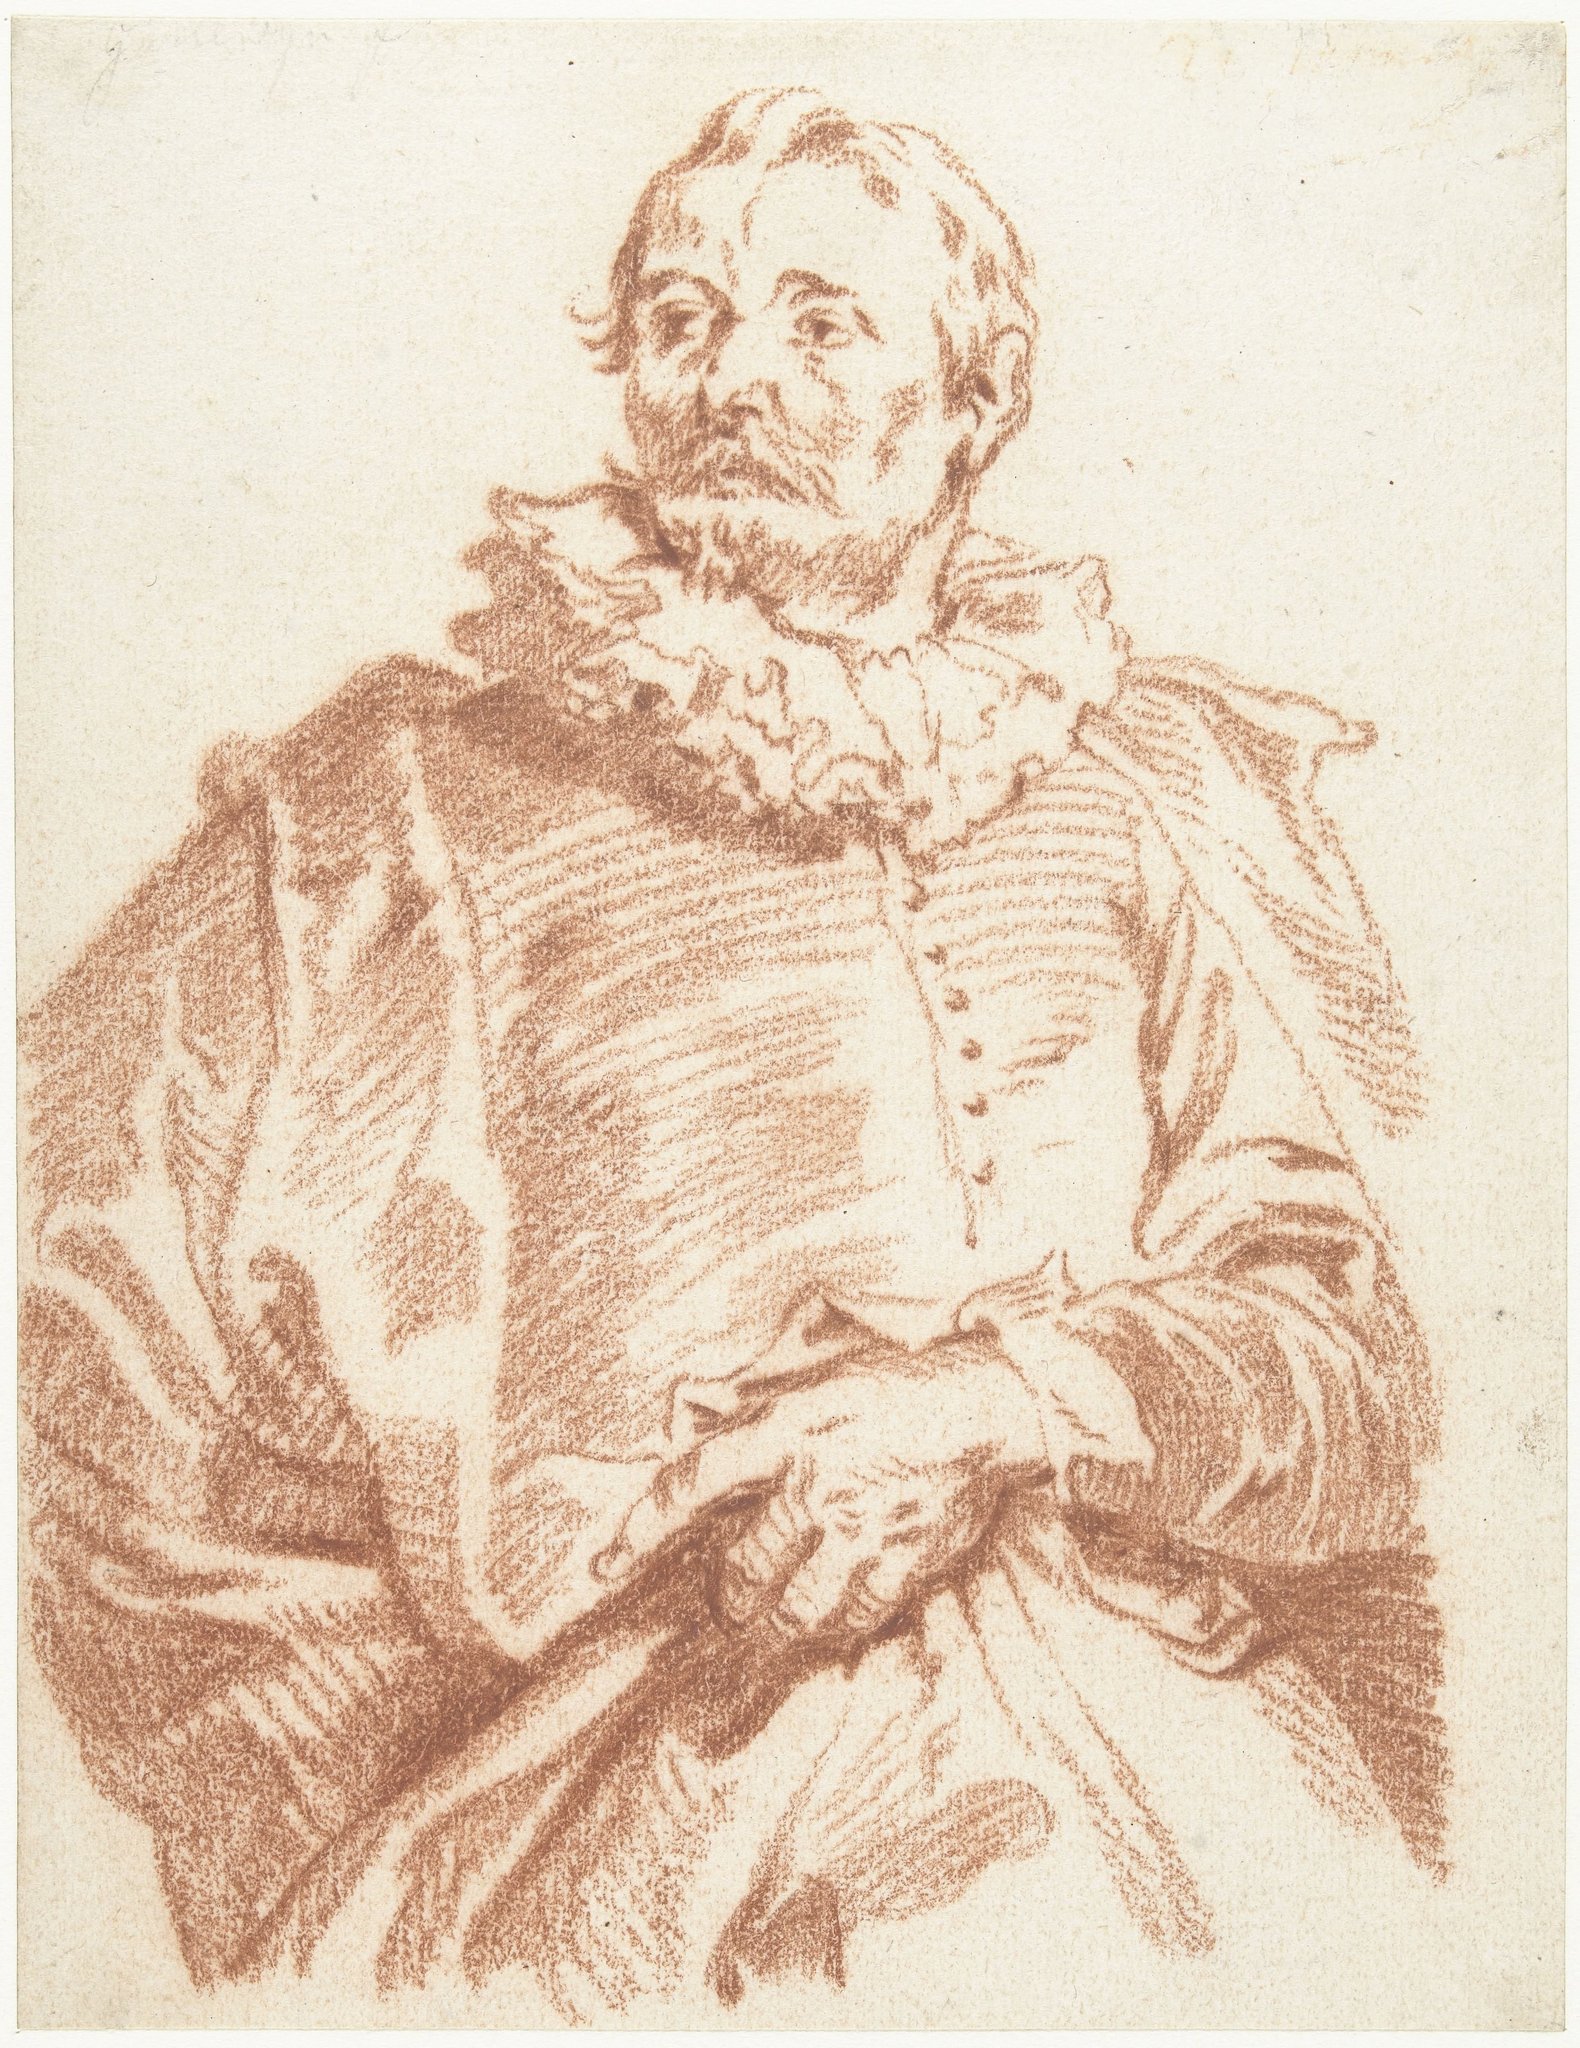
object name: drawing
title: Portret van Adriaen van Stalbemt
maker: Anonymous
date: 1627-1691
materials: chalk, paper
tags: antwerp, painter, print maker, adriaen van stalbemt, historical persons, portrait, self-portrait of painter